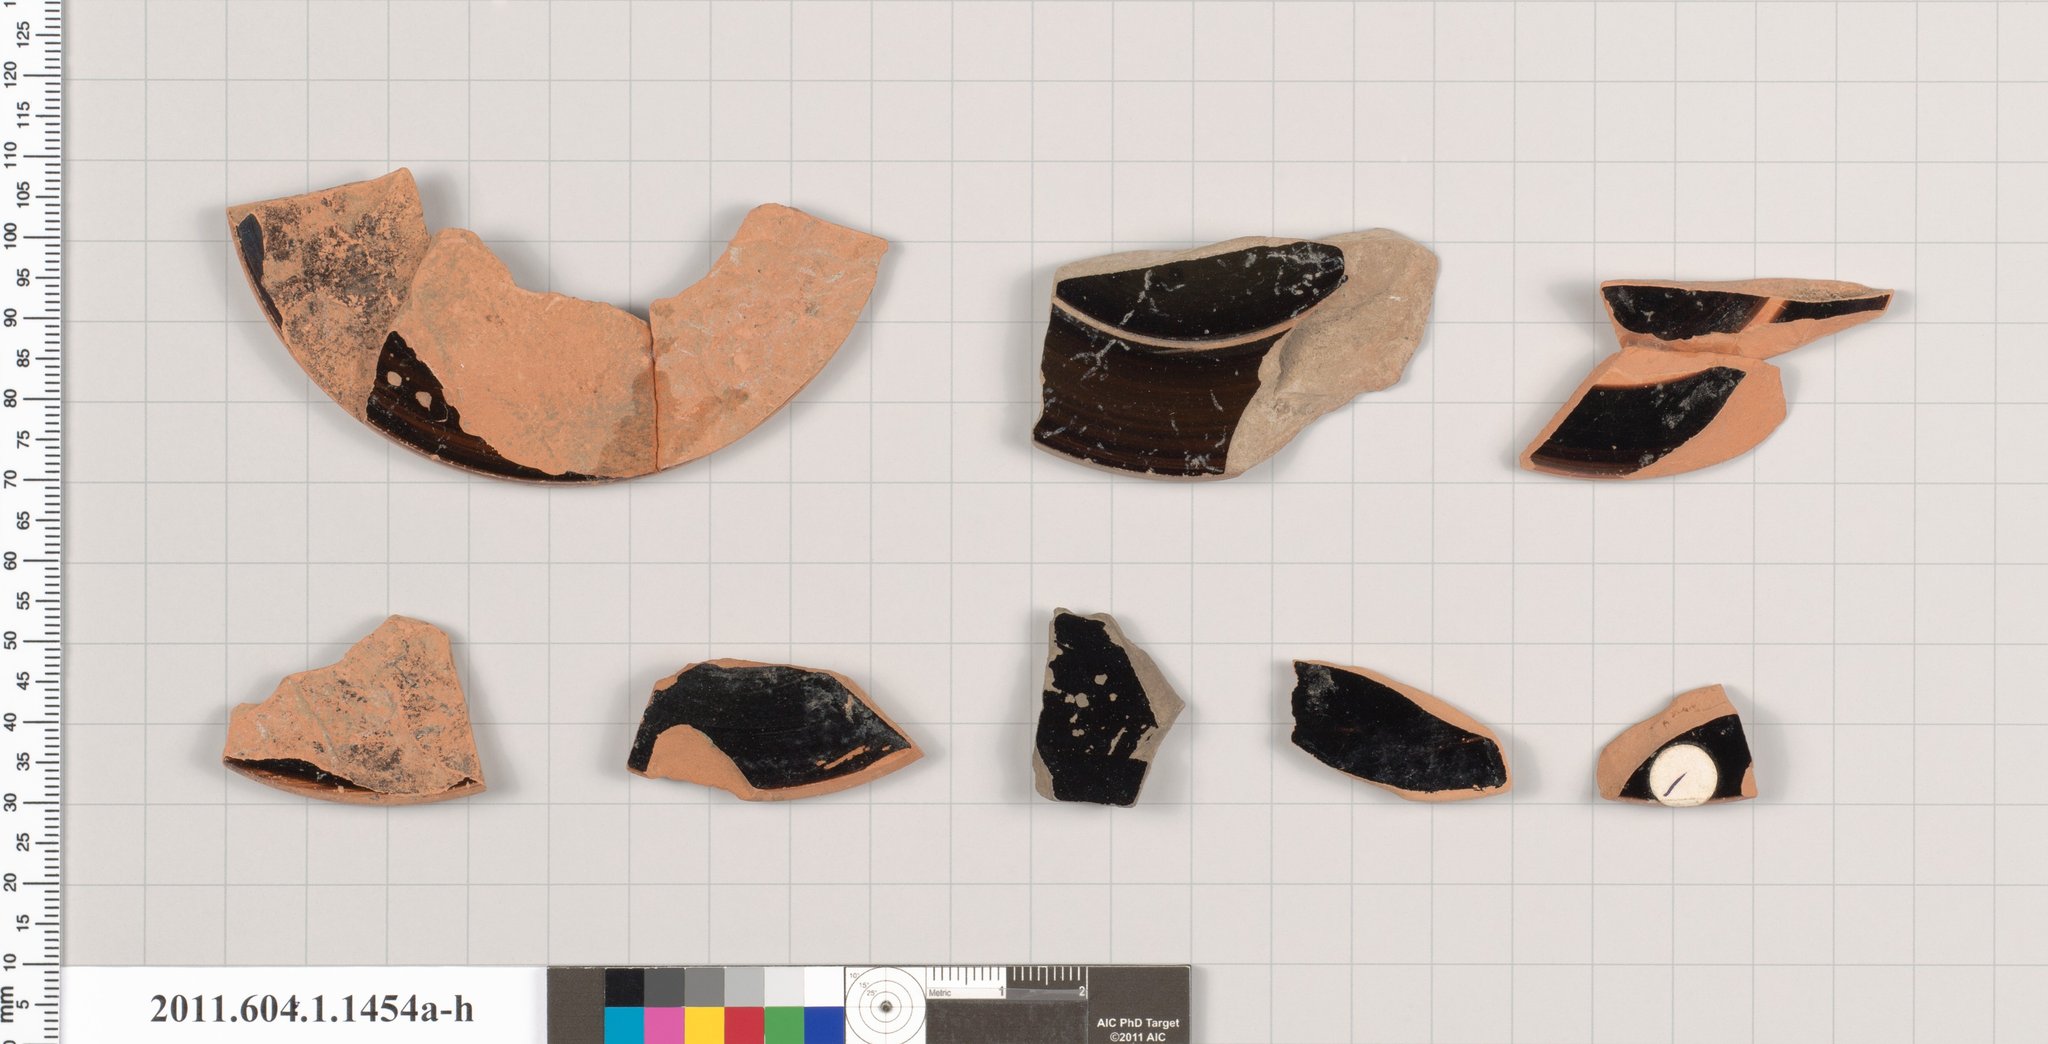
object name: kylix fragment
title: Terracotta fragments of kylikes (drinking cups)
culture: greek, attic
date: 500-401 BCE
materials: terracotta